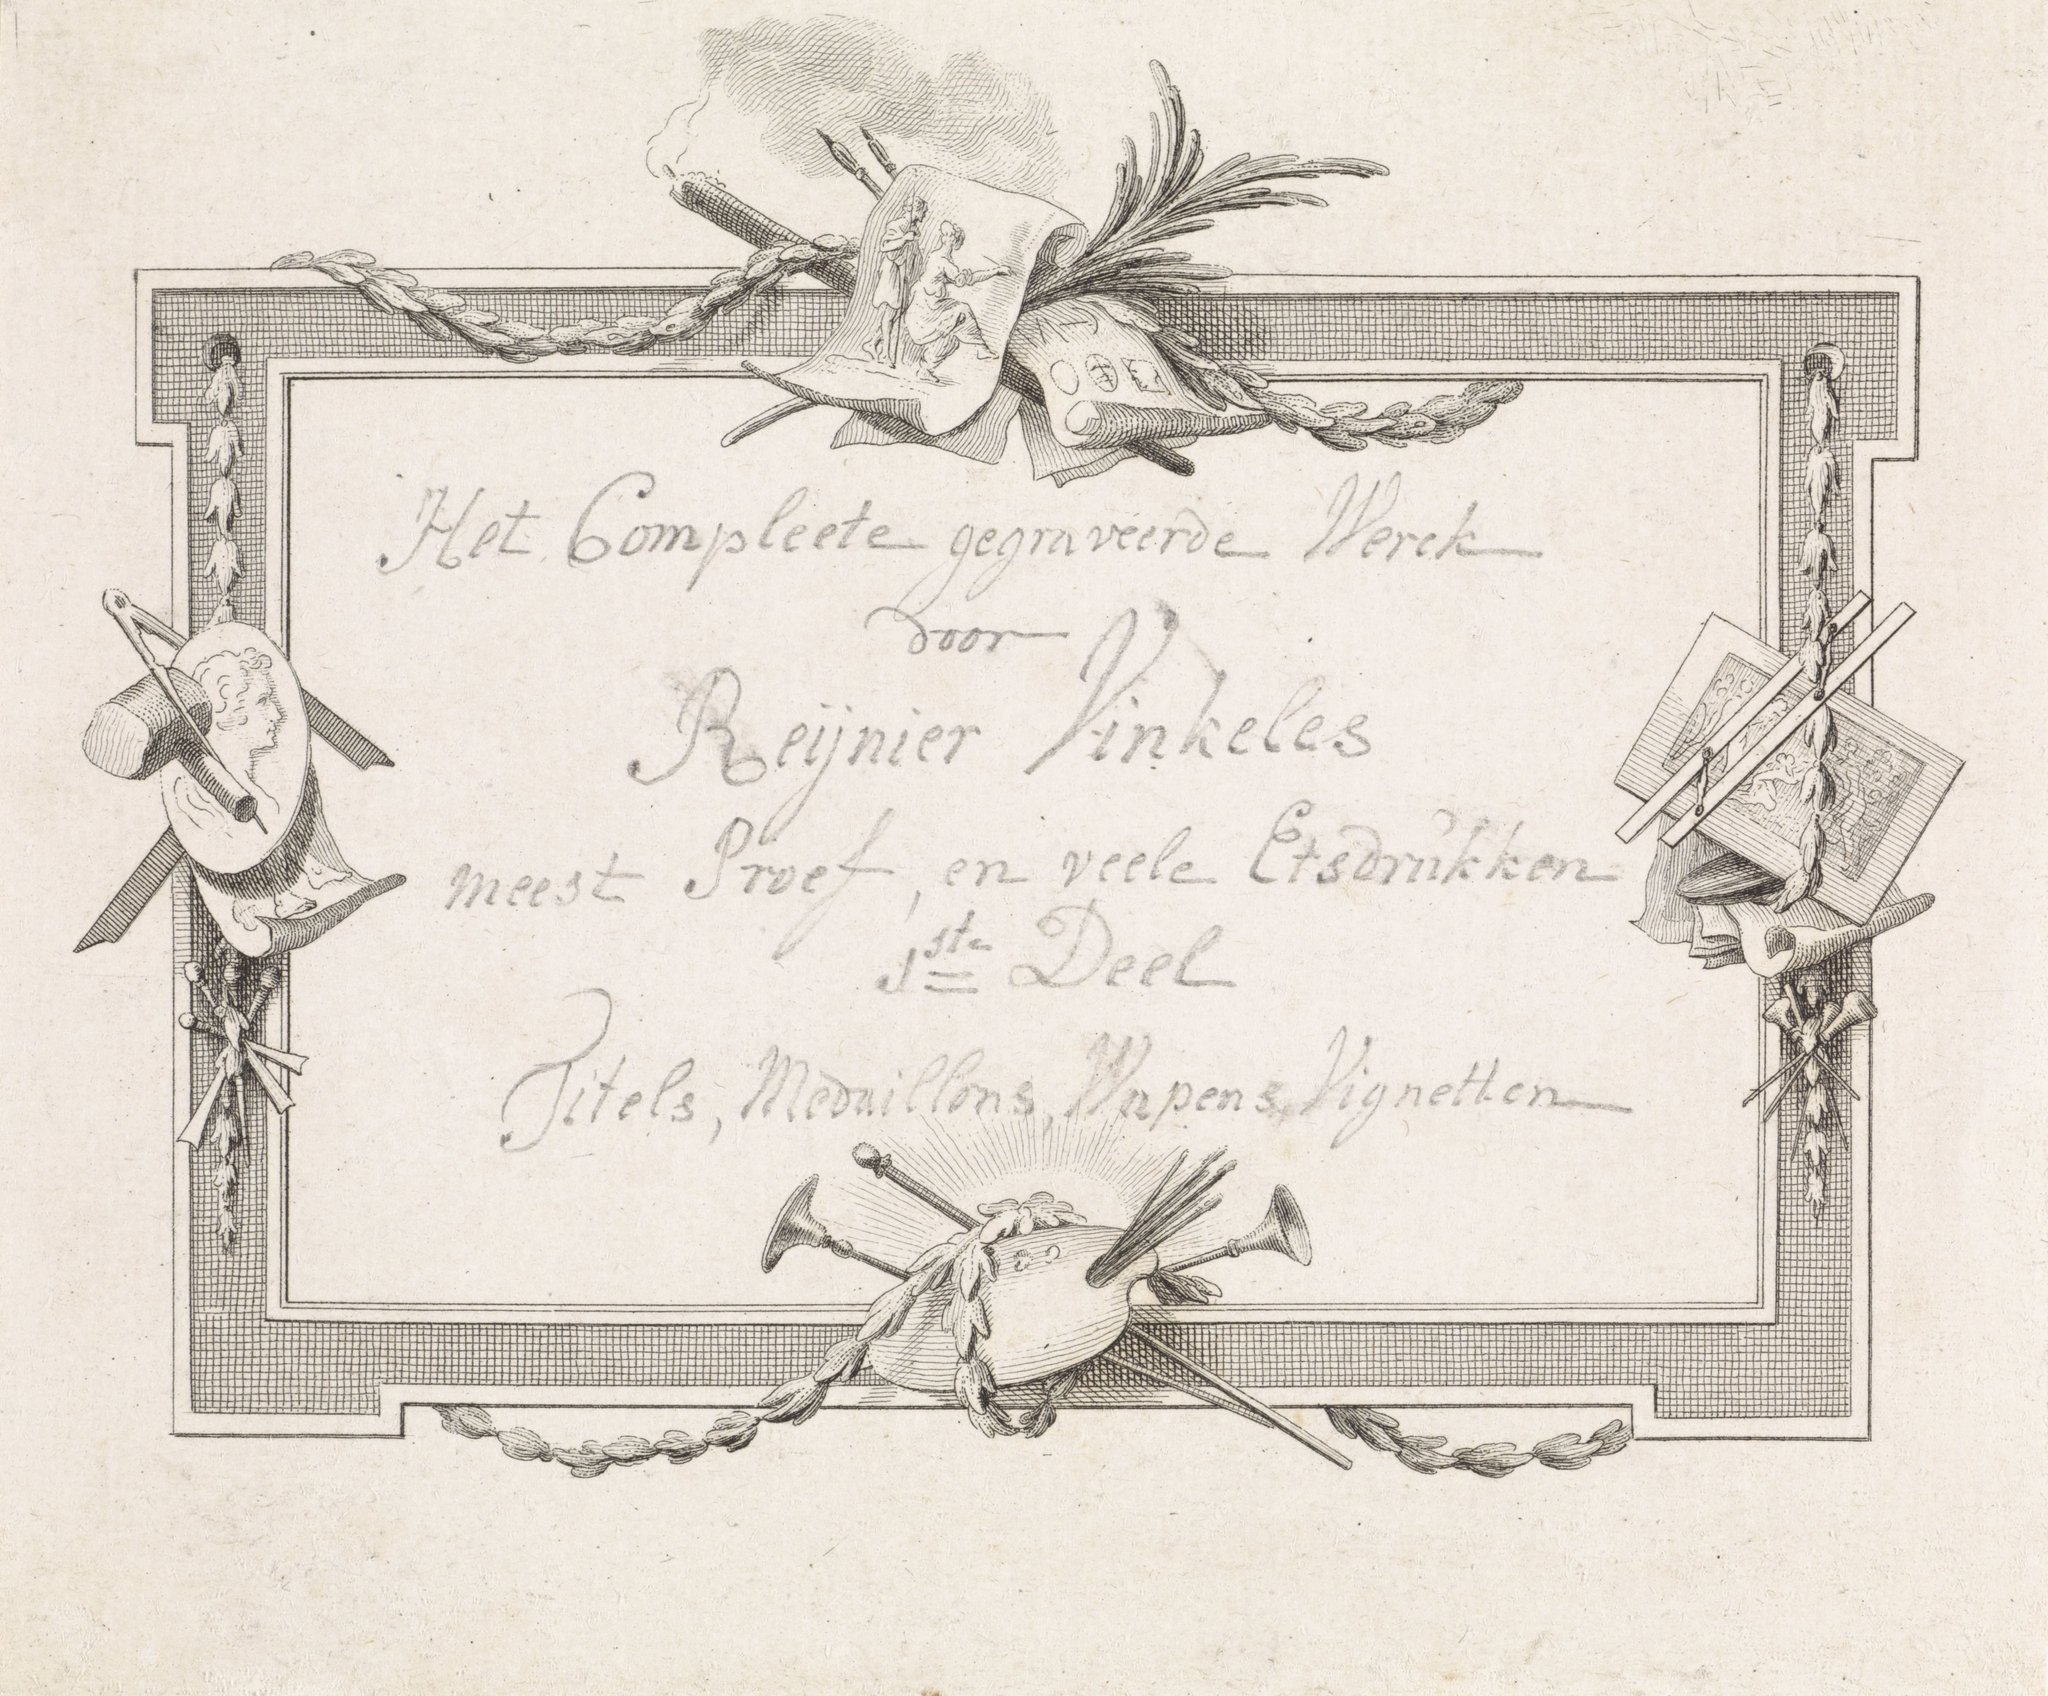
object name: print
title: Titelpagina voor "Het Complete gegraveerde Werck door Reijnier Vinkeles, meest Proef, en veele Etsdrukken, 1ste Deel, Titels, Medaillons, Wapens, Vignetten"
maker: reinier vinkeles (i)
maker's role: draughtsman, print maker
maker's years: 1741-1816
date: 1751-1816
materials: paper, pencil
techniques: engraving, etching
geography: amsterdam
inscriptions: collector's mark: Lugt 240